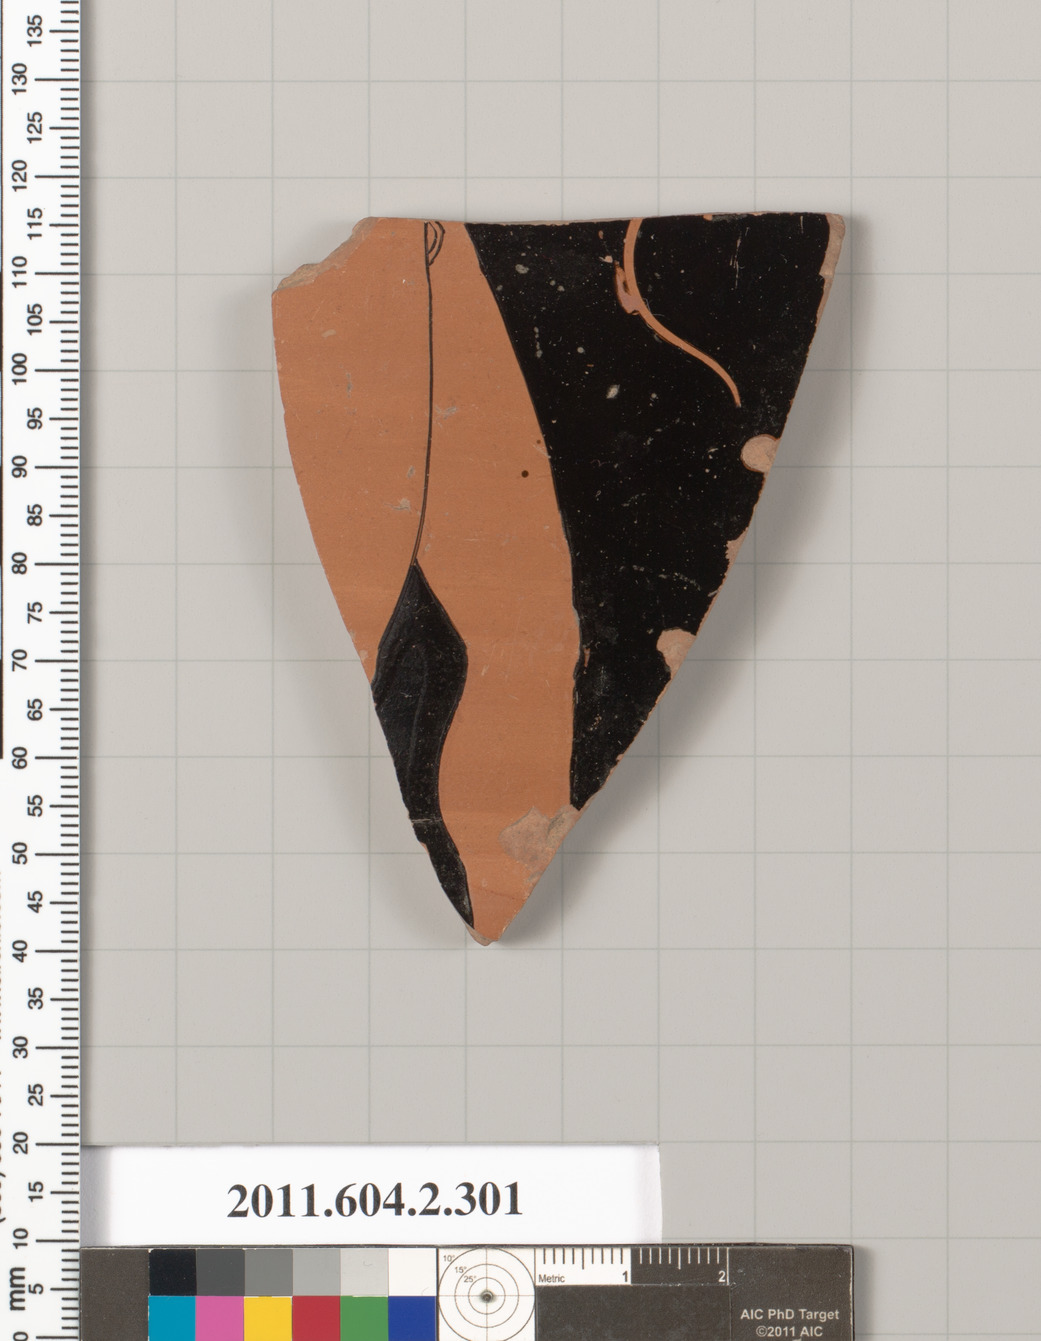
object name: column krater fragment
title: Terracotta fragment of a column-krater (bowl for mixing wine and water)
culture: greek, attic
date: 460-440 BCE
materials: terracotta